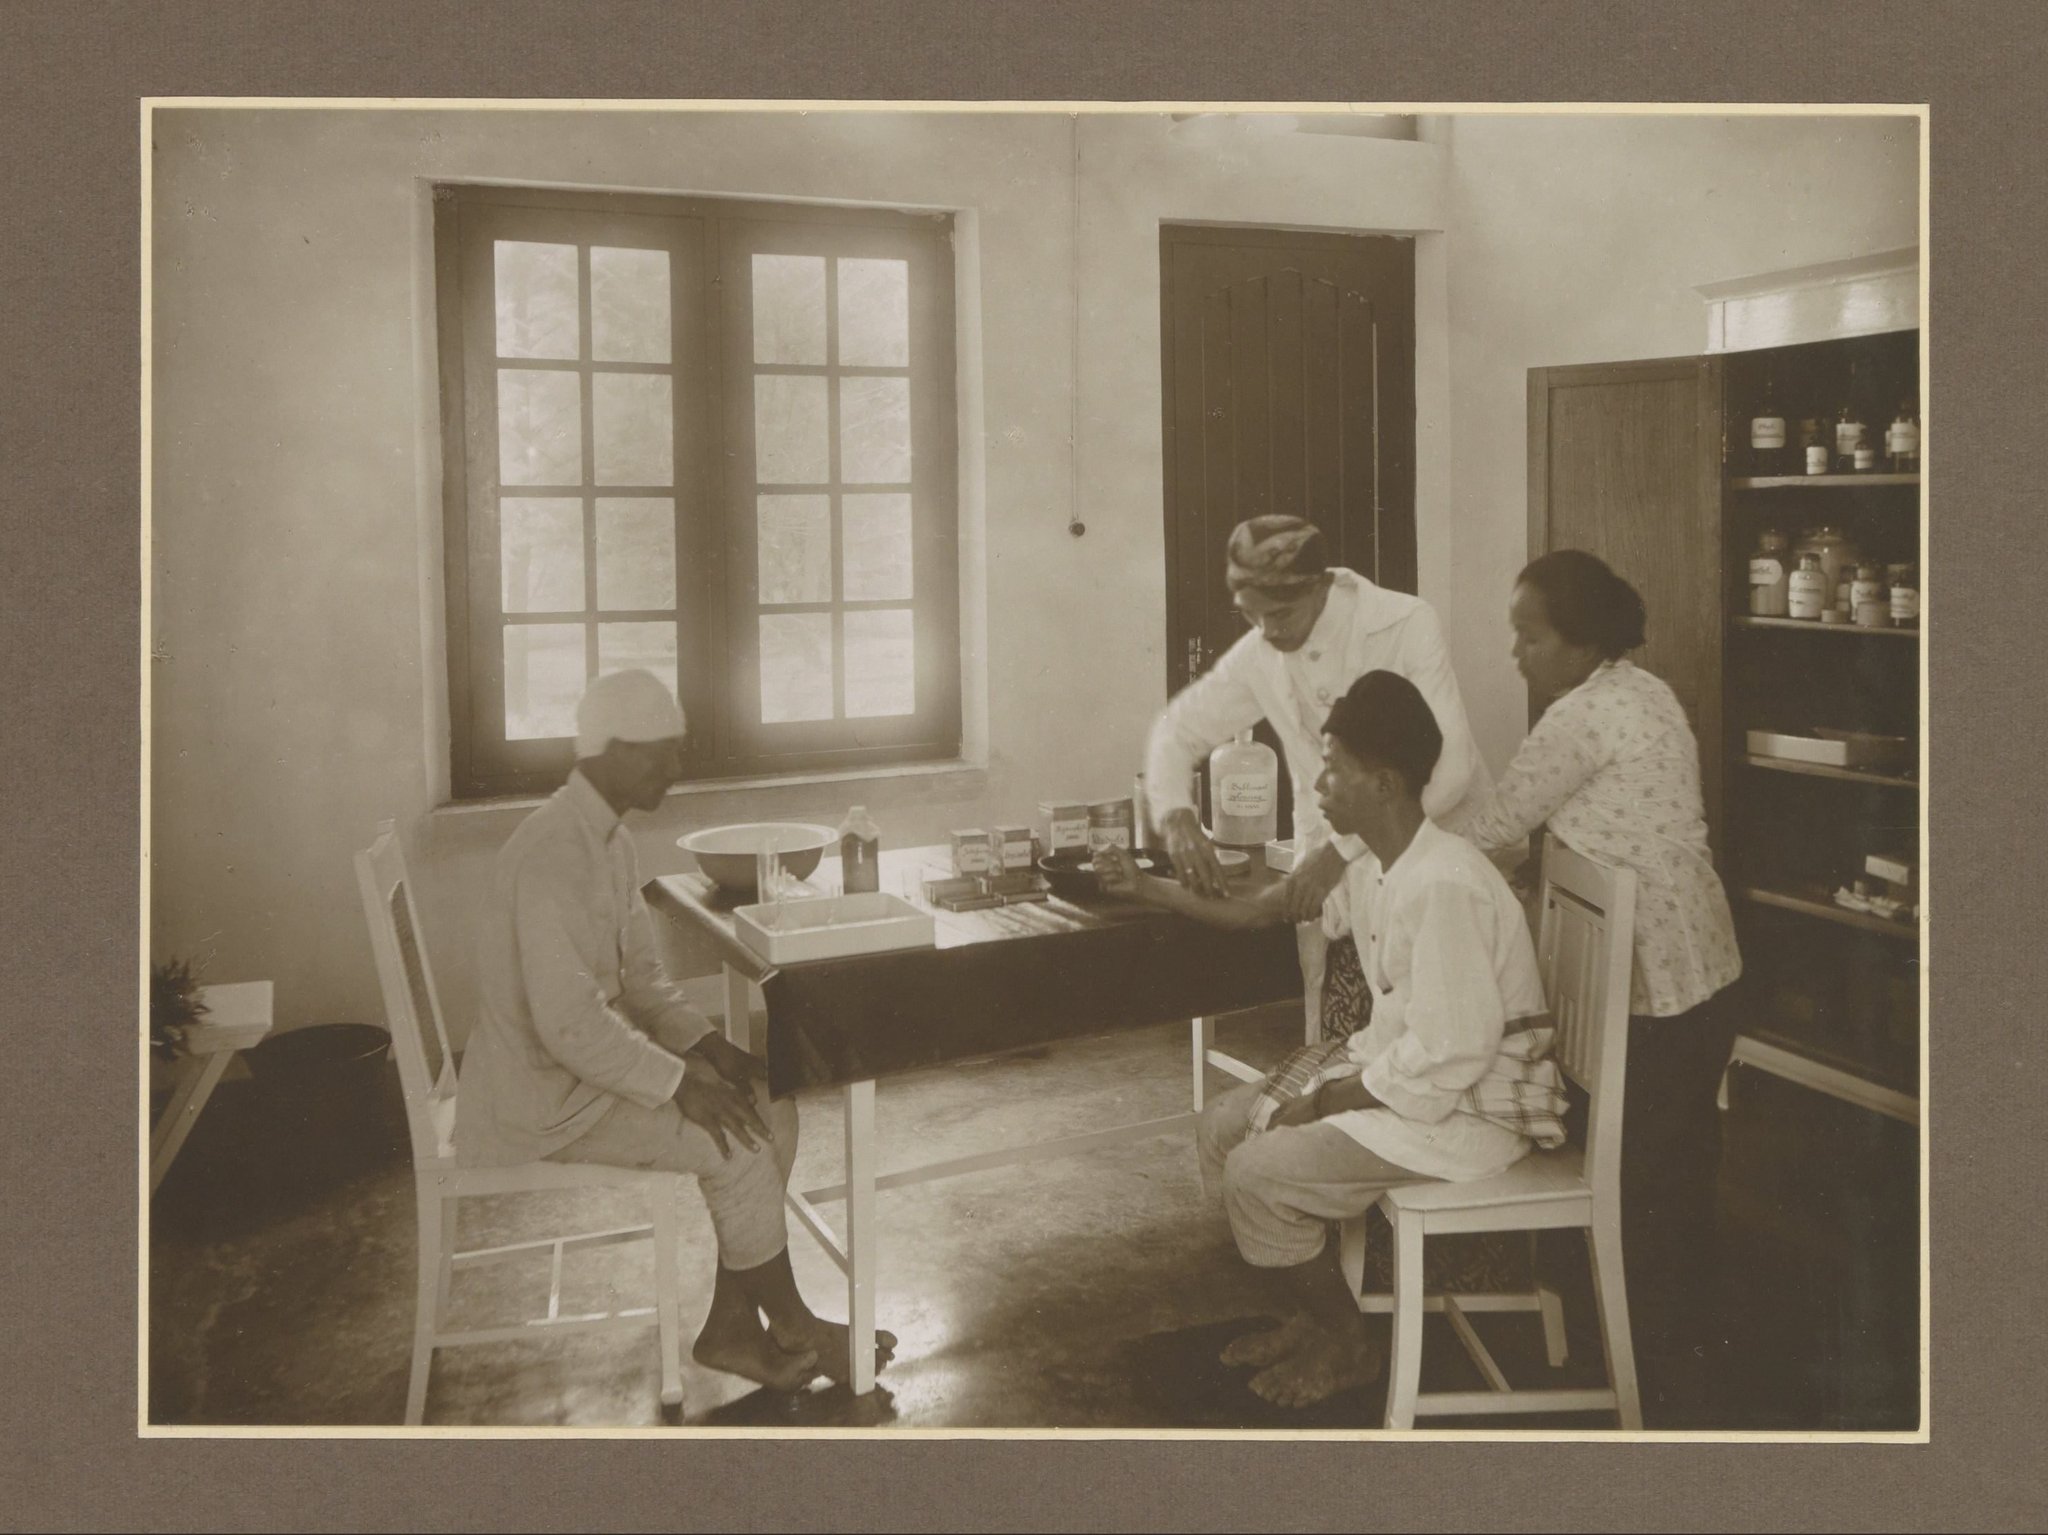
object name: album leaf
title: Sf. Ngandjoek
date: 1925-1930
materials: cardboard, paper, photographic support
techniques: gelatin silver print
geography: nganjuk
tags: plantation, physician, doctor, hospital, patient, sick person, plants and herbs: sugarcane, sugar, dutch east indies, the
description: Onderdeel van Fotoalbum met opnames van vier suikerfabrieken op Java.